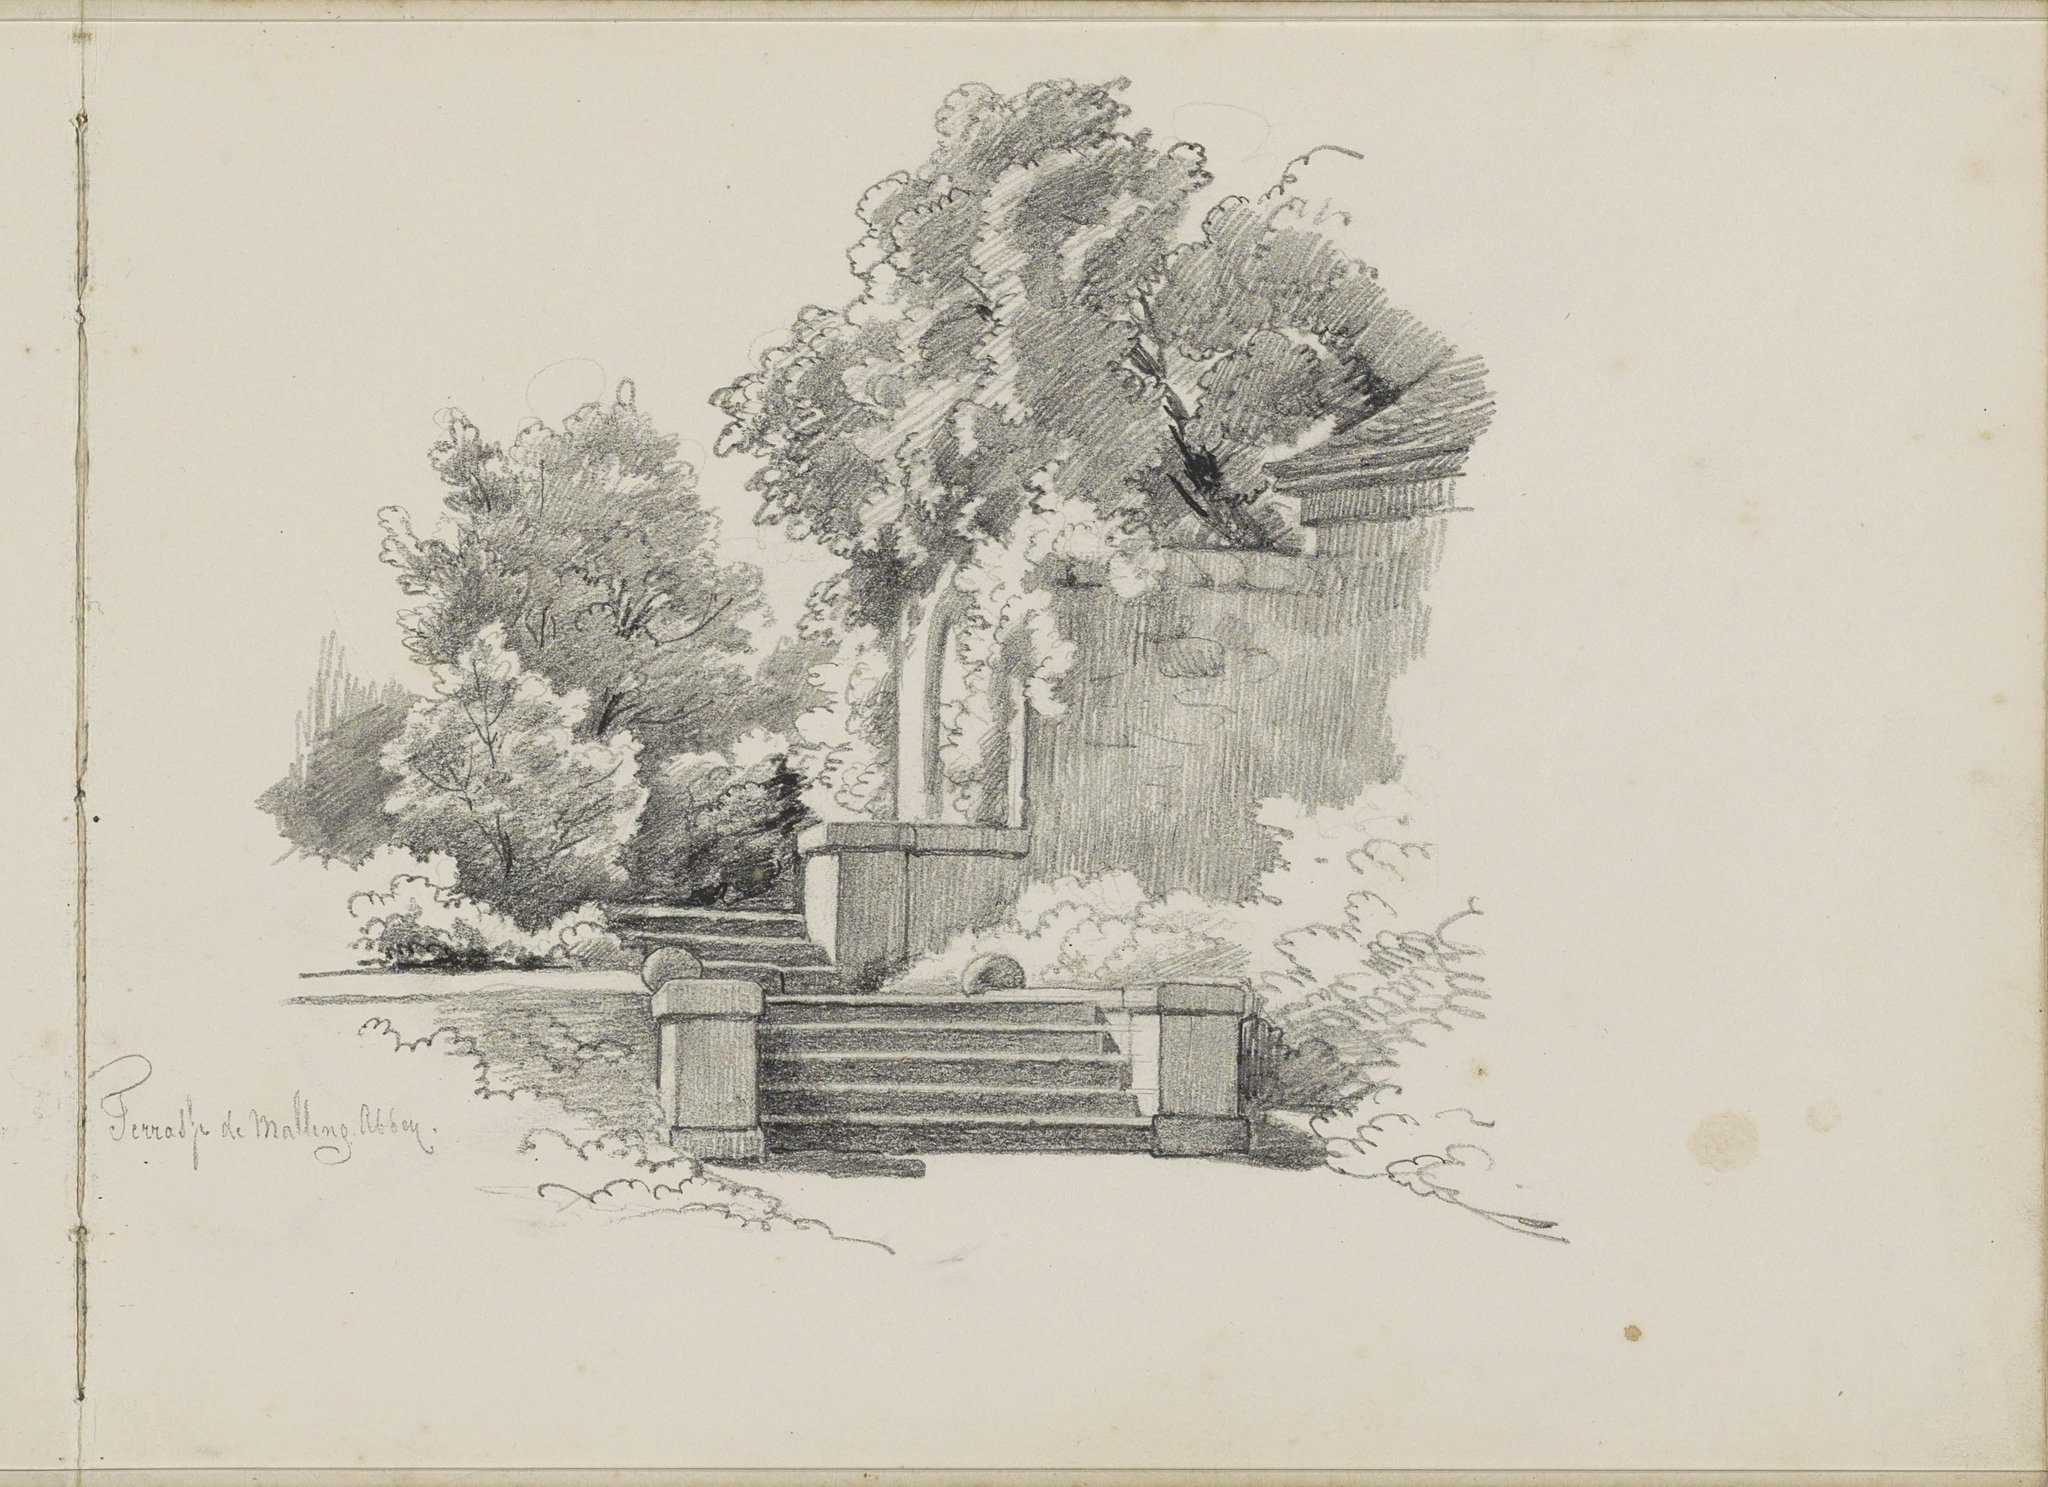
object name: sketchbook leaf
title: Trap bij Malling Abbey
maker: gerrit postma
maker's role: draughtsman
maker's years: 1819-1894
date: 1858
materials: paper, pencil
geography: west malling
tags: flight of steps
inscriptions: annotation: ‘Terras[...] de Malling Abbey.’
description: Blad 29 recto uit een schetsboek met 52 bladen.